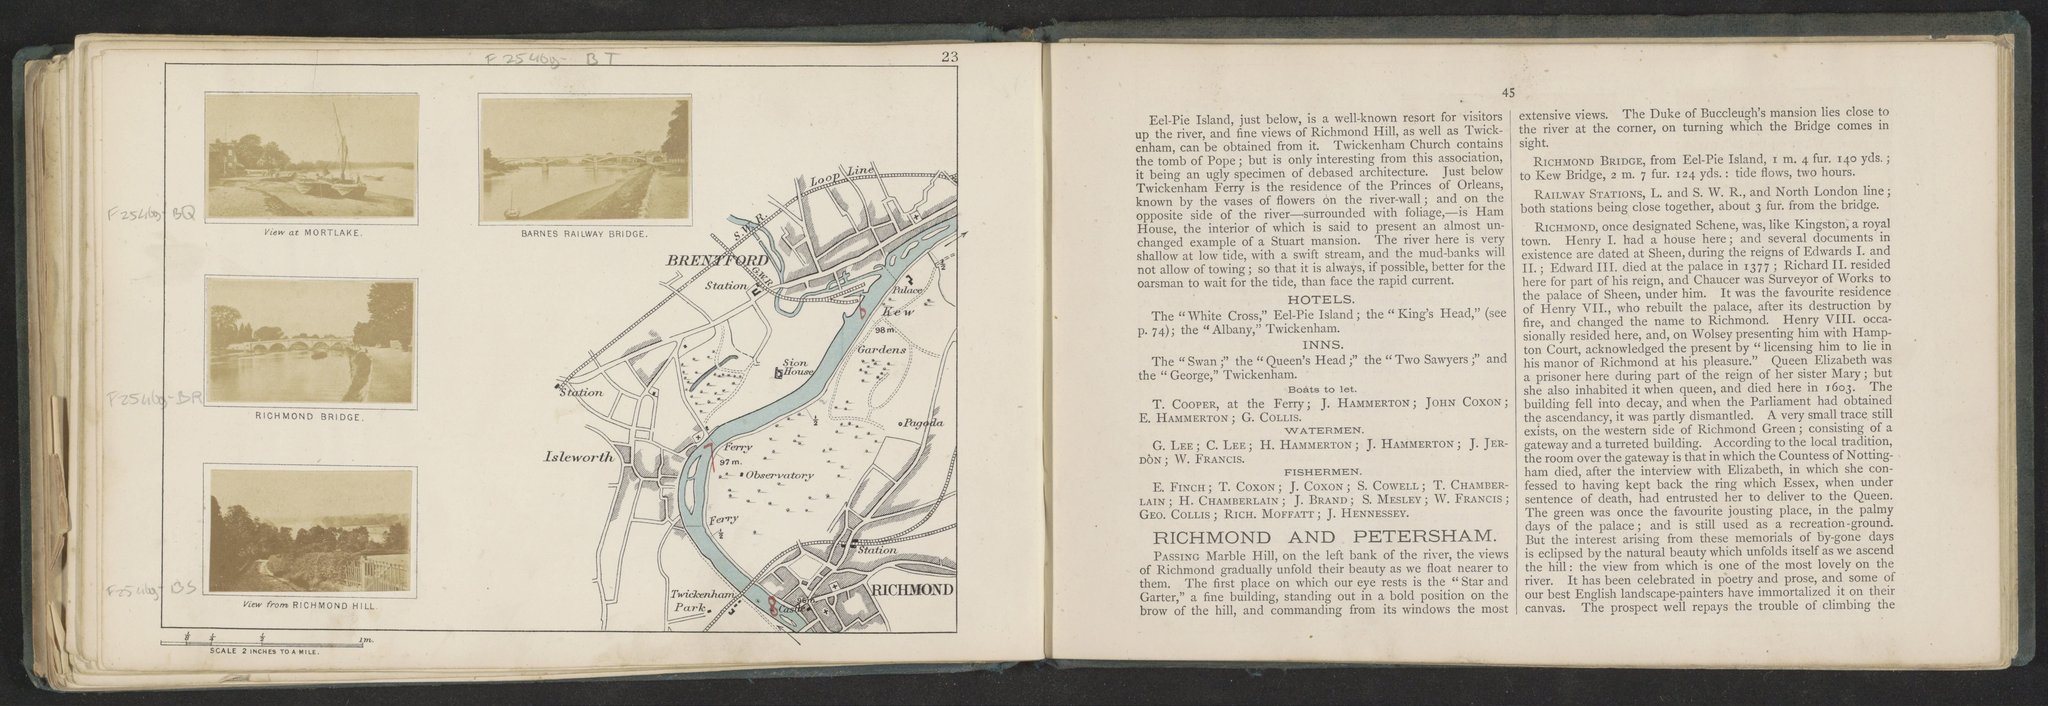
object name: page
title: Richmond bridge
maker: henry w. taunt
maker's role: fotograaf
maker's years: 1842-1922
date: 1871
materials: photographic support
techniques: albumen print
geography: richmond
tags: river, bridge, thames